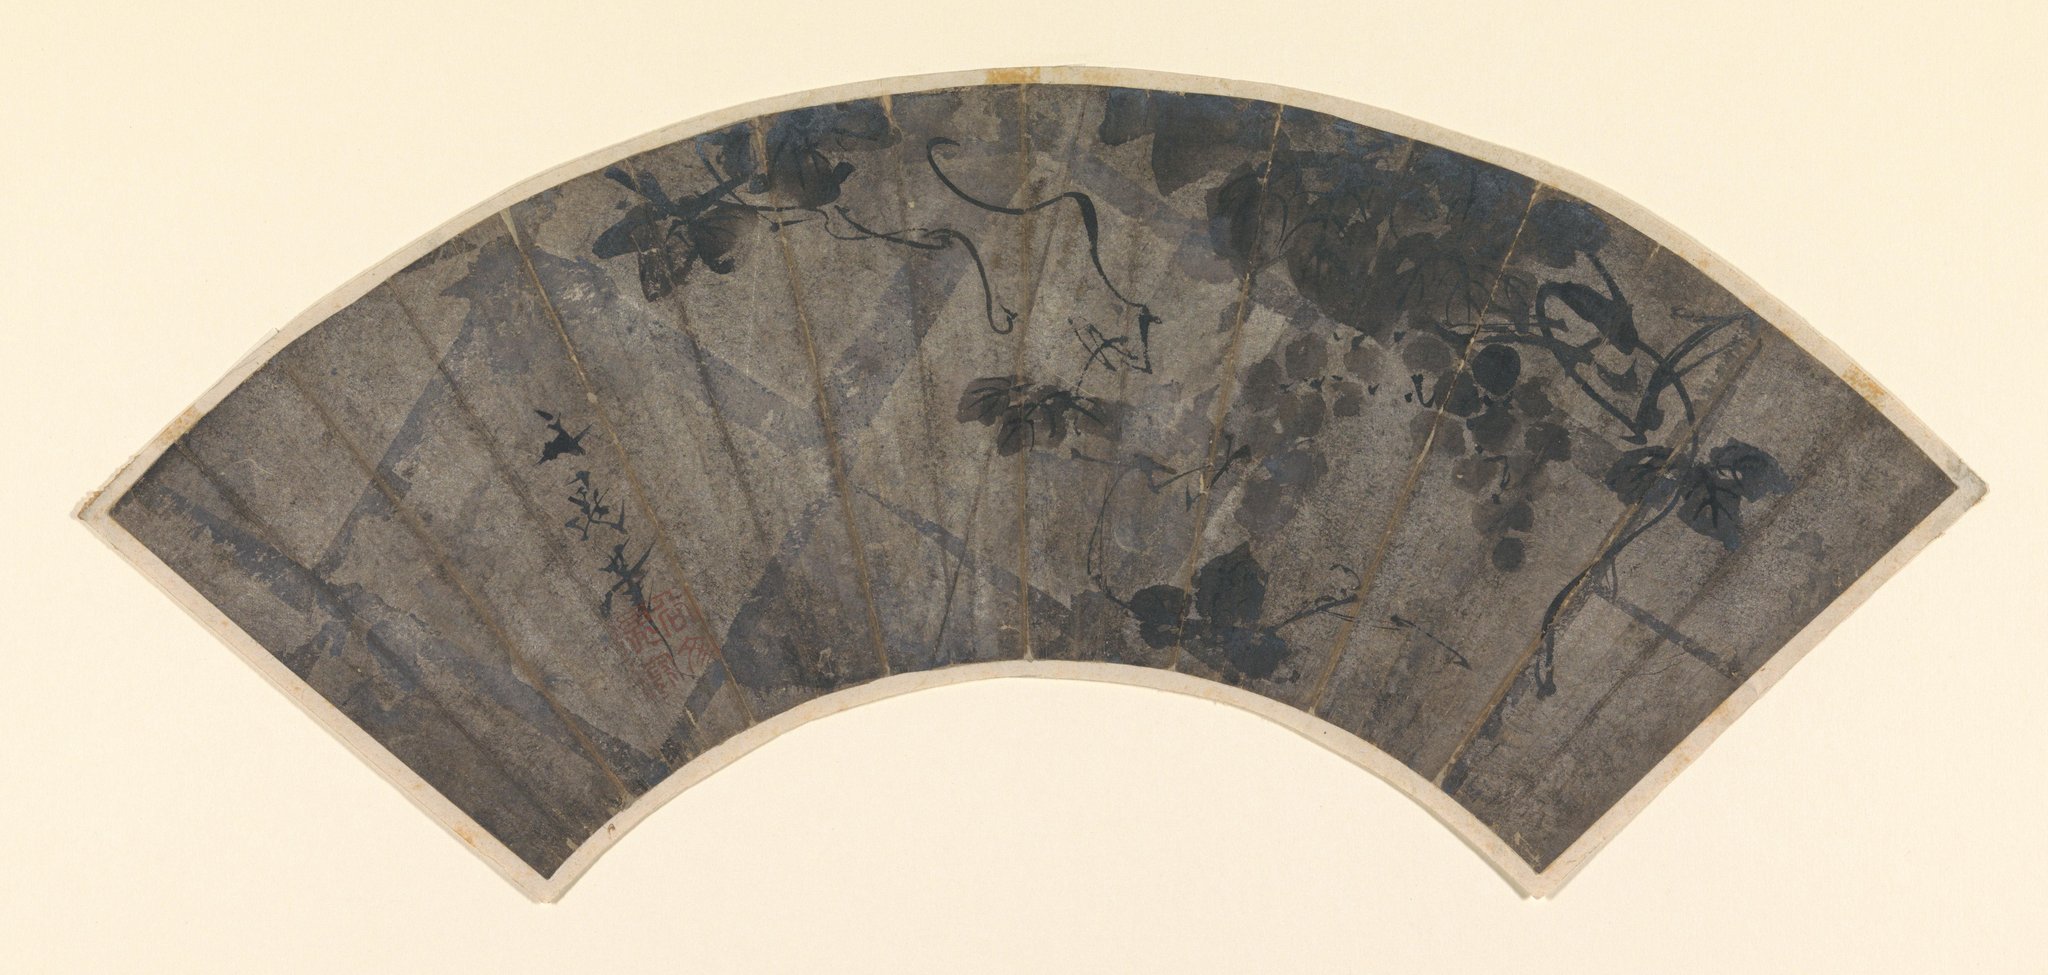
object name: drawing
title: Waaierblad met druiven en wijnranken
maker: tani buncho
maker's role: draughtsman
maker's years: 1763-1842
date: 1800-1900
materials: paint, paper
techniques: brush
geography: japan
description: Waaierblad, inkt op zilverfond op papier. Zegel van de kunstenaar in rood.